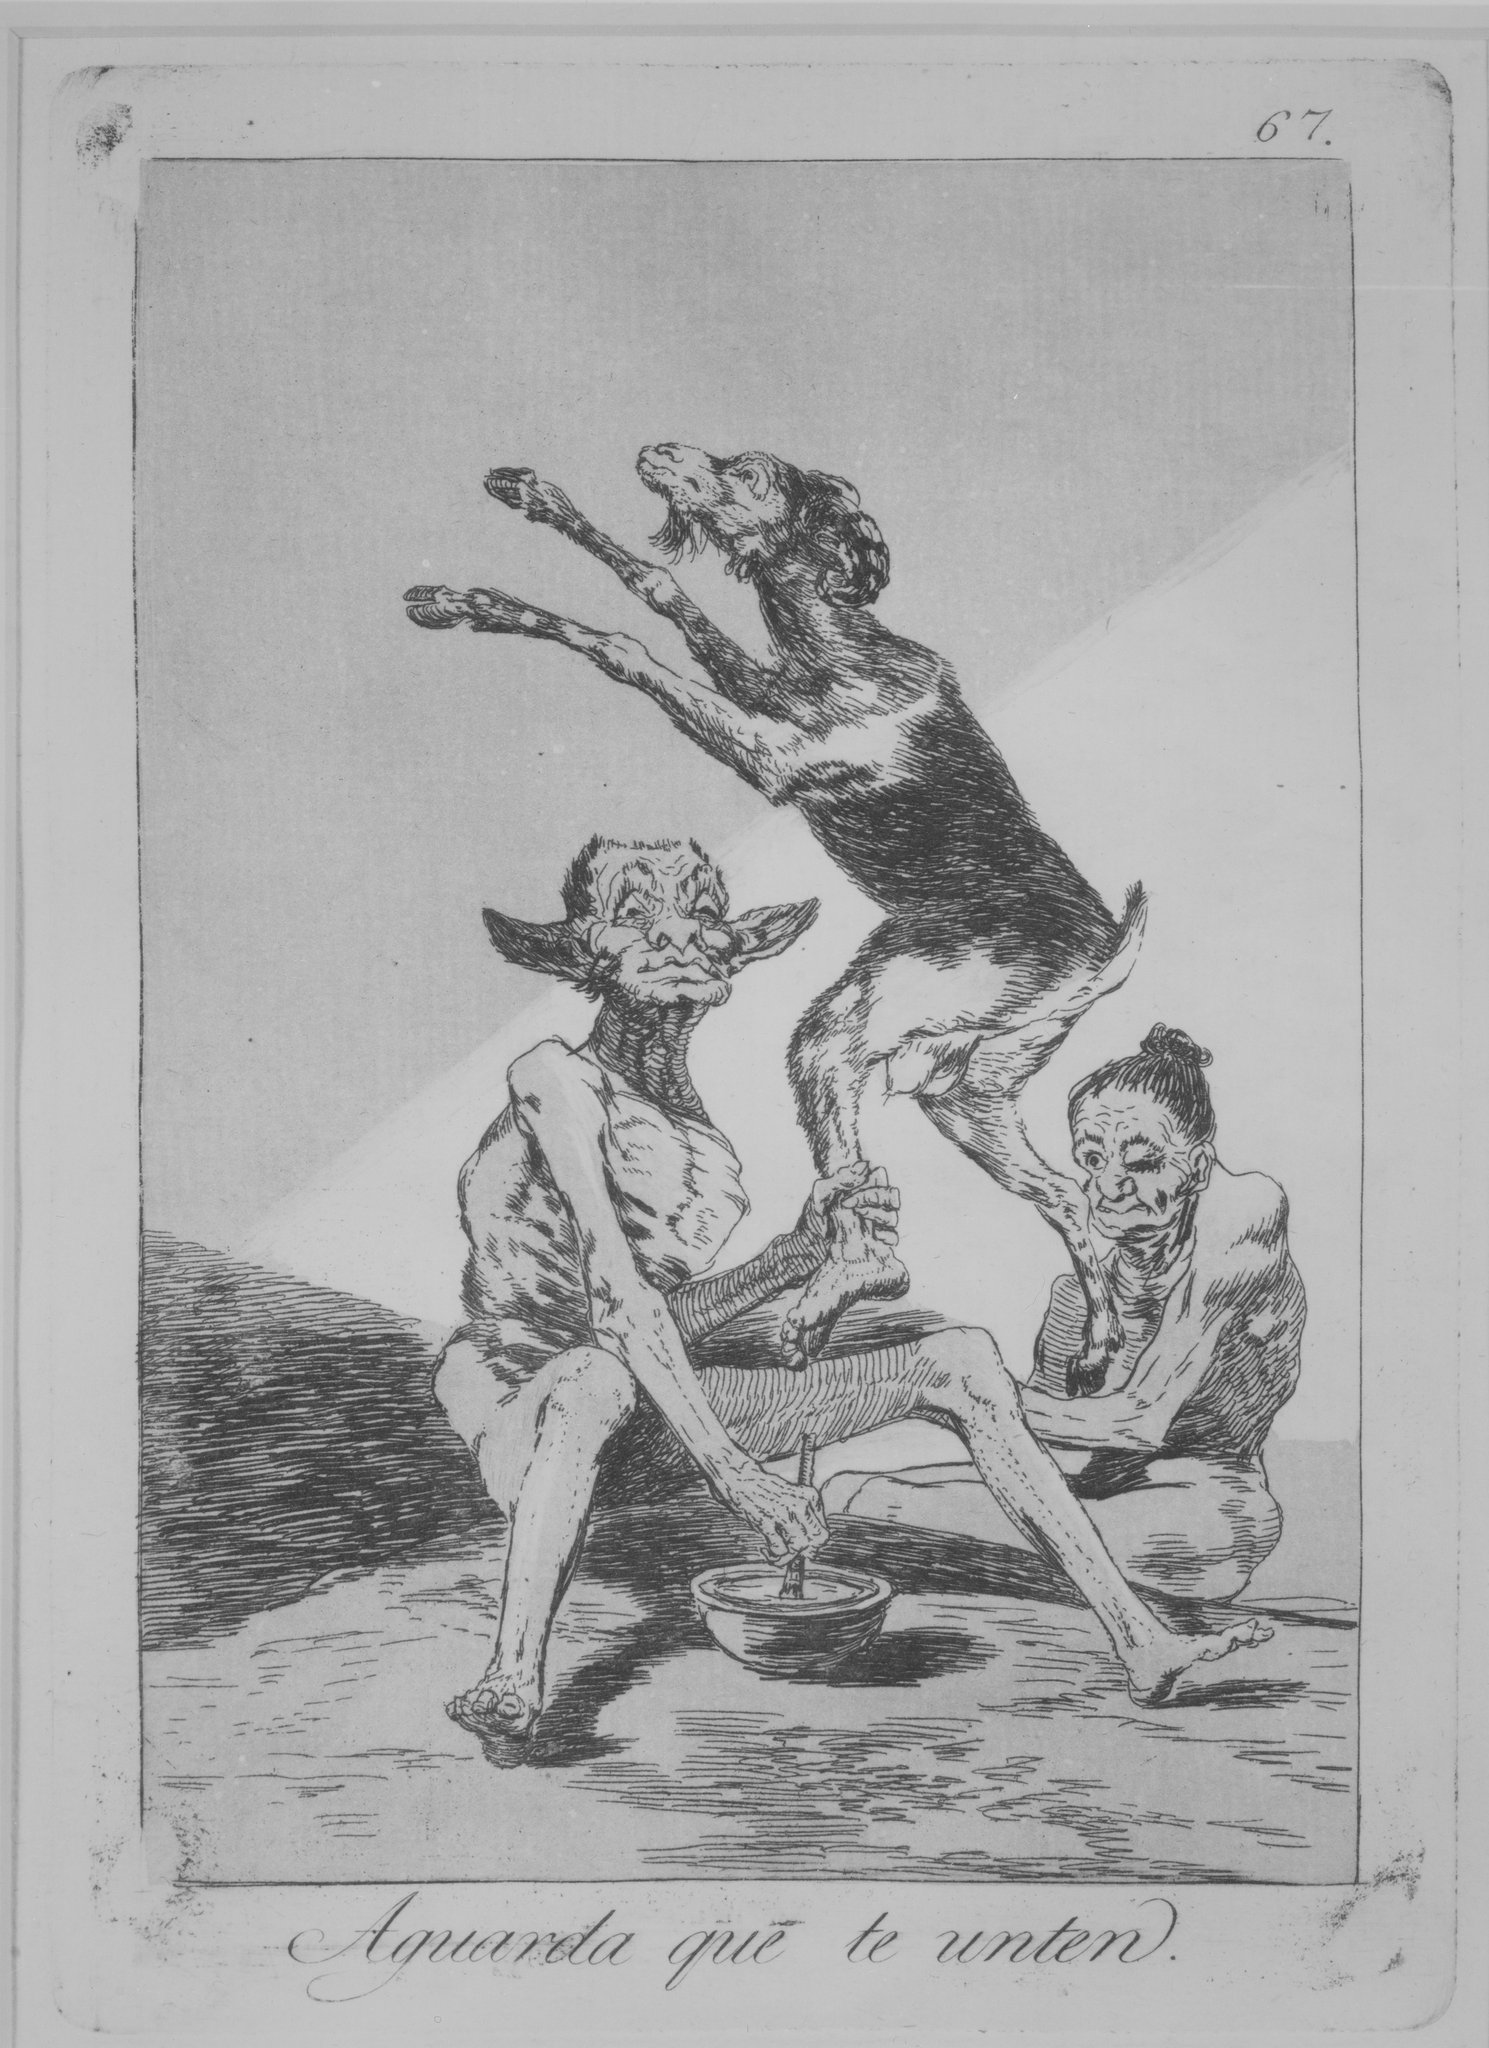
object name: print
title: The Caprices (Los Caprichos), plates 1-80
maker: goya (francisco de goya y lucientes)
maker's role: artist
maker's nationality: spanish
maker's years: 1746-1828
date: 1799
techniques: aquatint, engraving, drypoint, etching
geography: spain